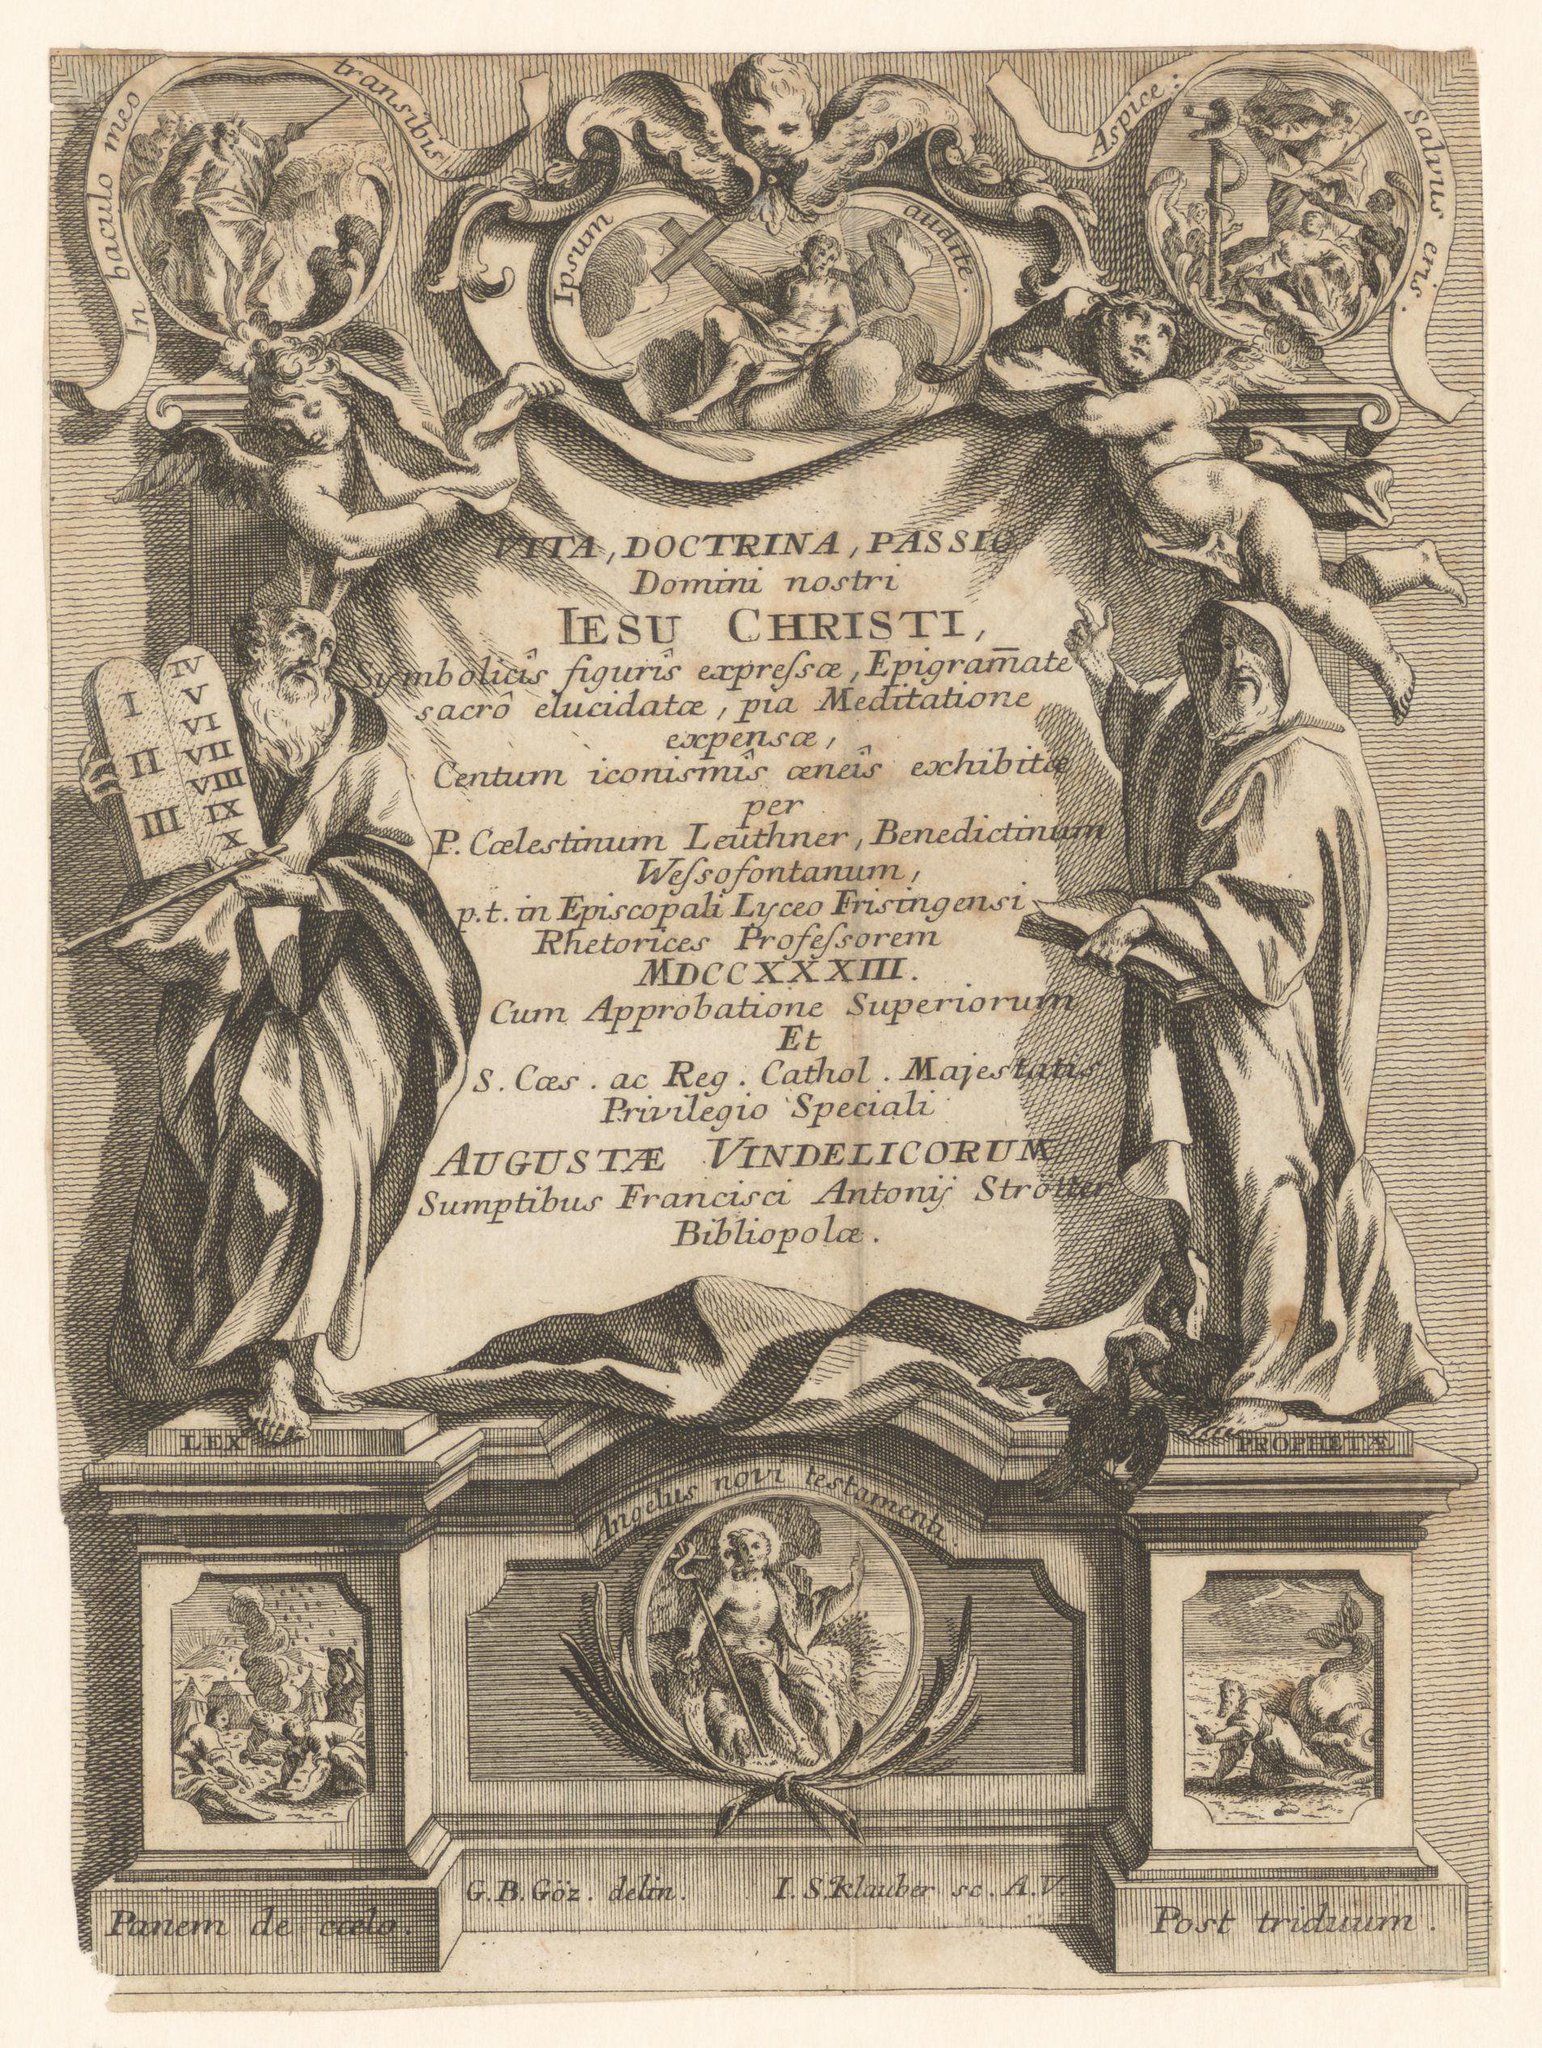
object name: print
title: Titelpagina voor: Coelestin Leuthner, Vita. Doctrina. Passio (...), 1733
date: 1733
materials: paper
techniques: engraving, etching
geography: augsburg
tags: title-page, moses (not in biblical context); possible attributes: rays of light or horns on his head, rod, tables of the law, new testament, ornament ~ cartouche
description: Deze prent is waarschijnlijk gebruikt voor een latere uitgave van: Leuthner, Coelestin. Vita, Doctrina, Passio (...) Bibliopola. Augsburg: Francicus Antonius Strötter, 1733.